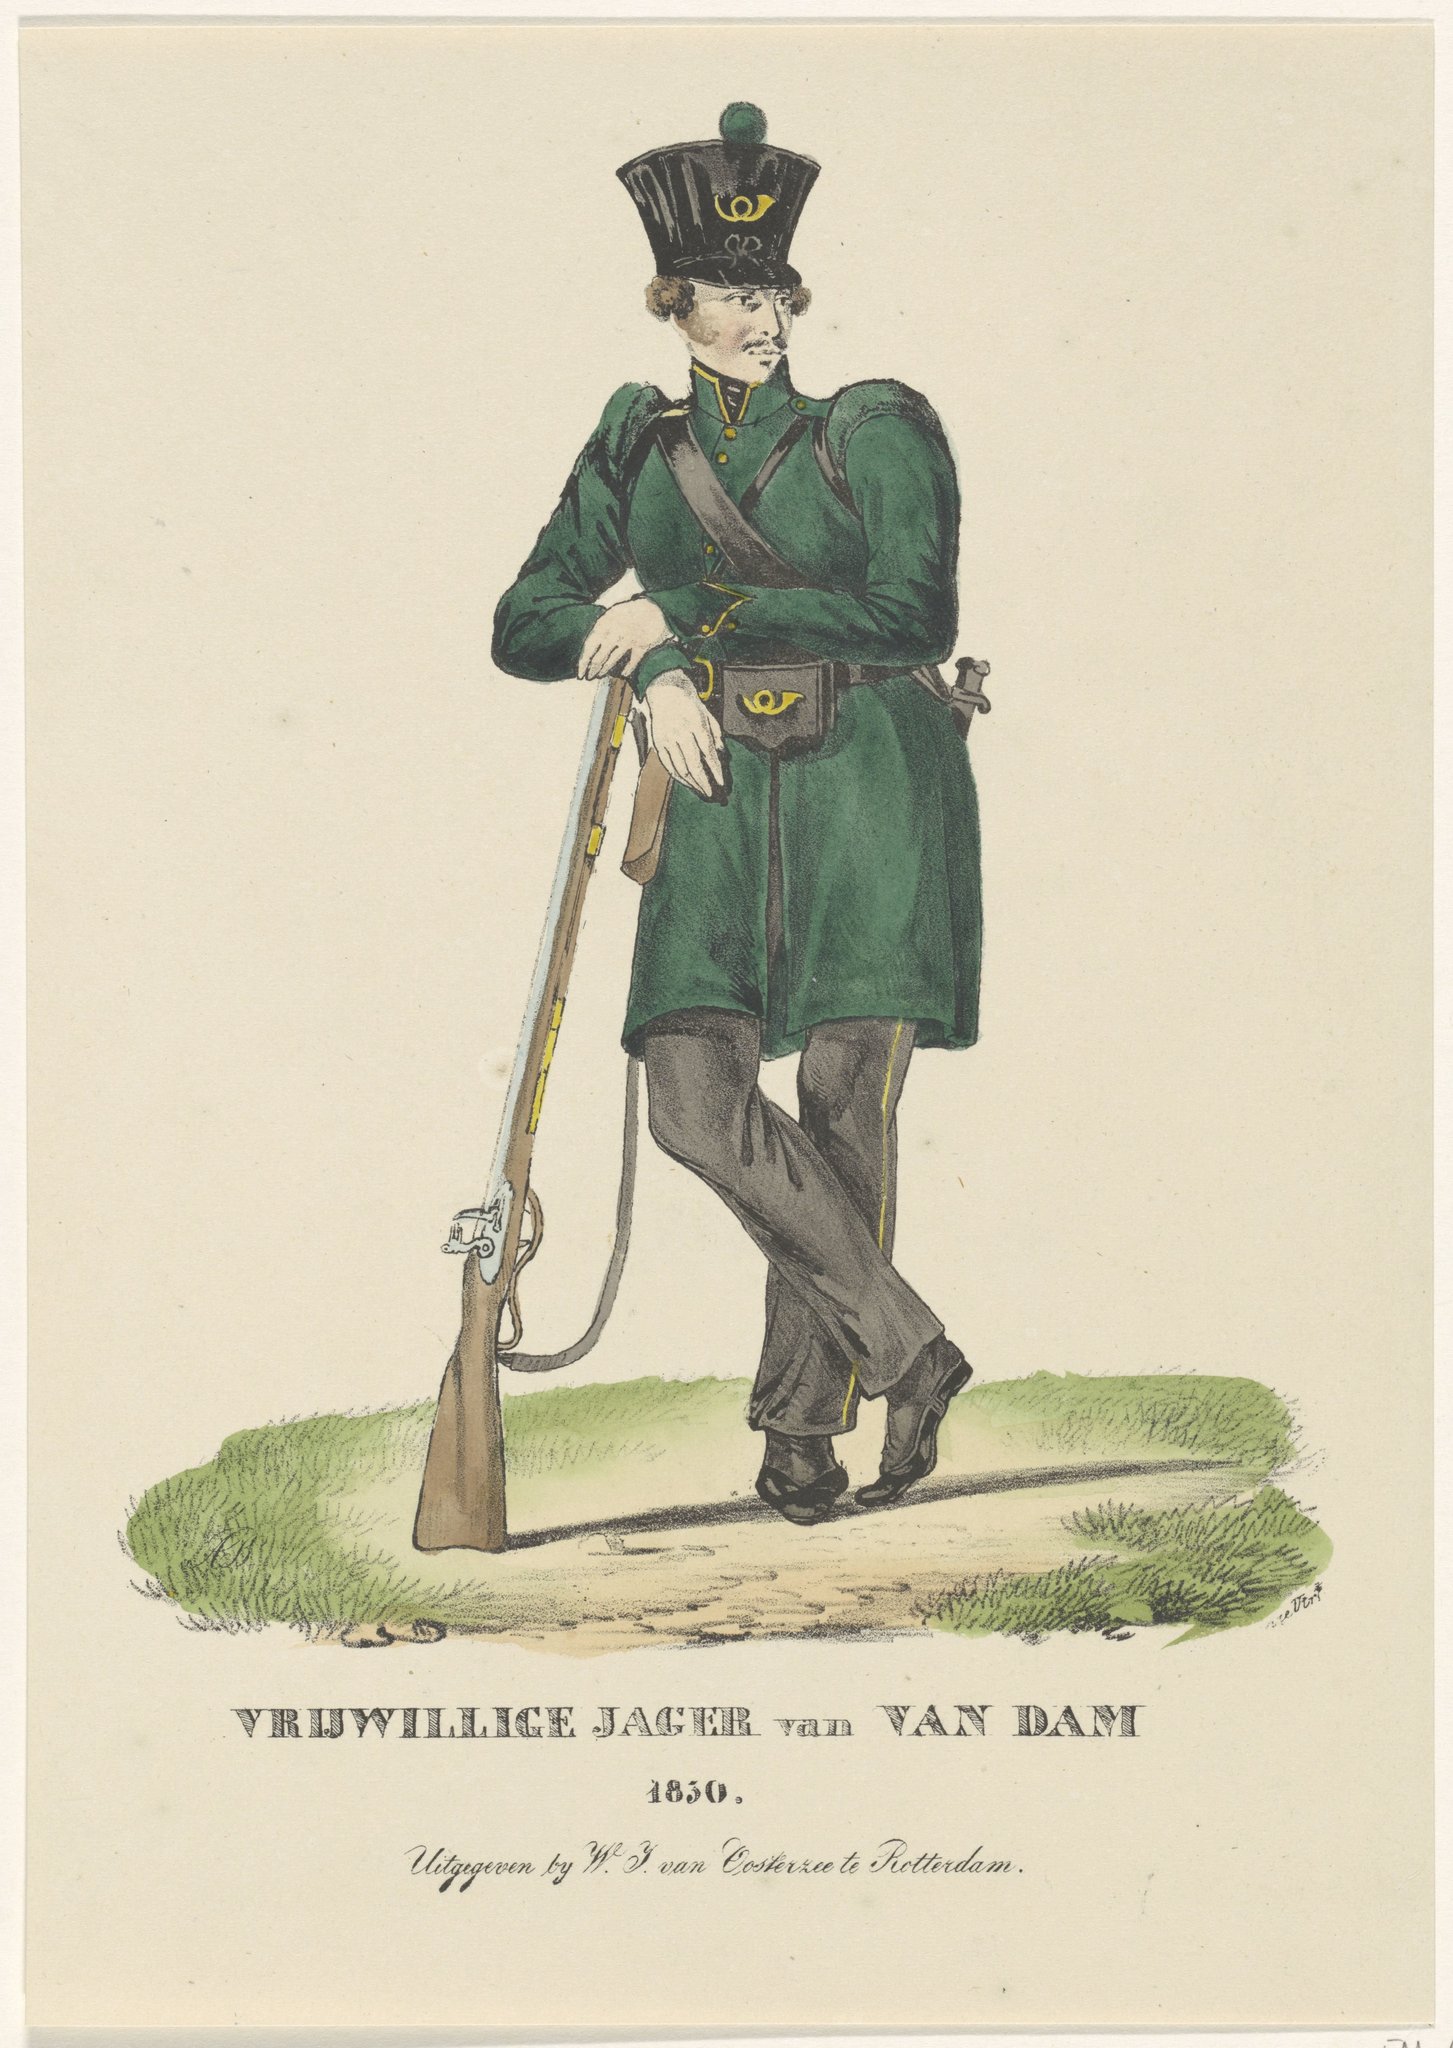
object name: print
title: Vrijwillige Jager van Van Dam, 1830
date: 1830-1831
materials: paper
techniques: hand coloring, lithograph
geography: netherlands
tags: (military) uniforms, clothes, costume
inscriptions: collector's mark: Lugt 2228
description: Uniform van een Vrijwillige Jager van Van Dam, 1830. Staande, leunend op zijn geweer.